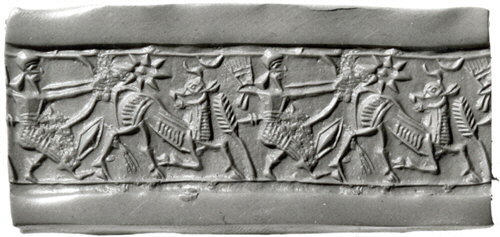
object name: cylinder seal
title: Cylinder seal with hunting scene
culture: assyrian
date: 900-701 BCE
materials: jasper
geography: mesopotamia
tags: animals,men,hunting